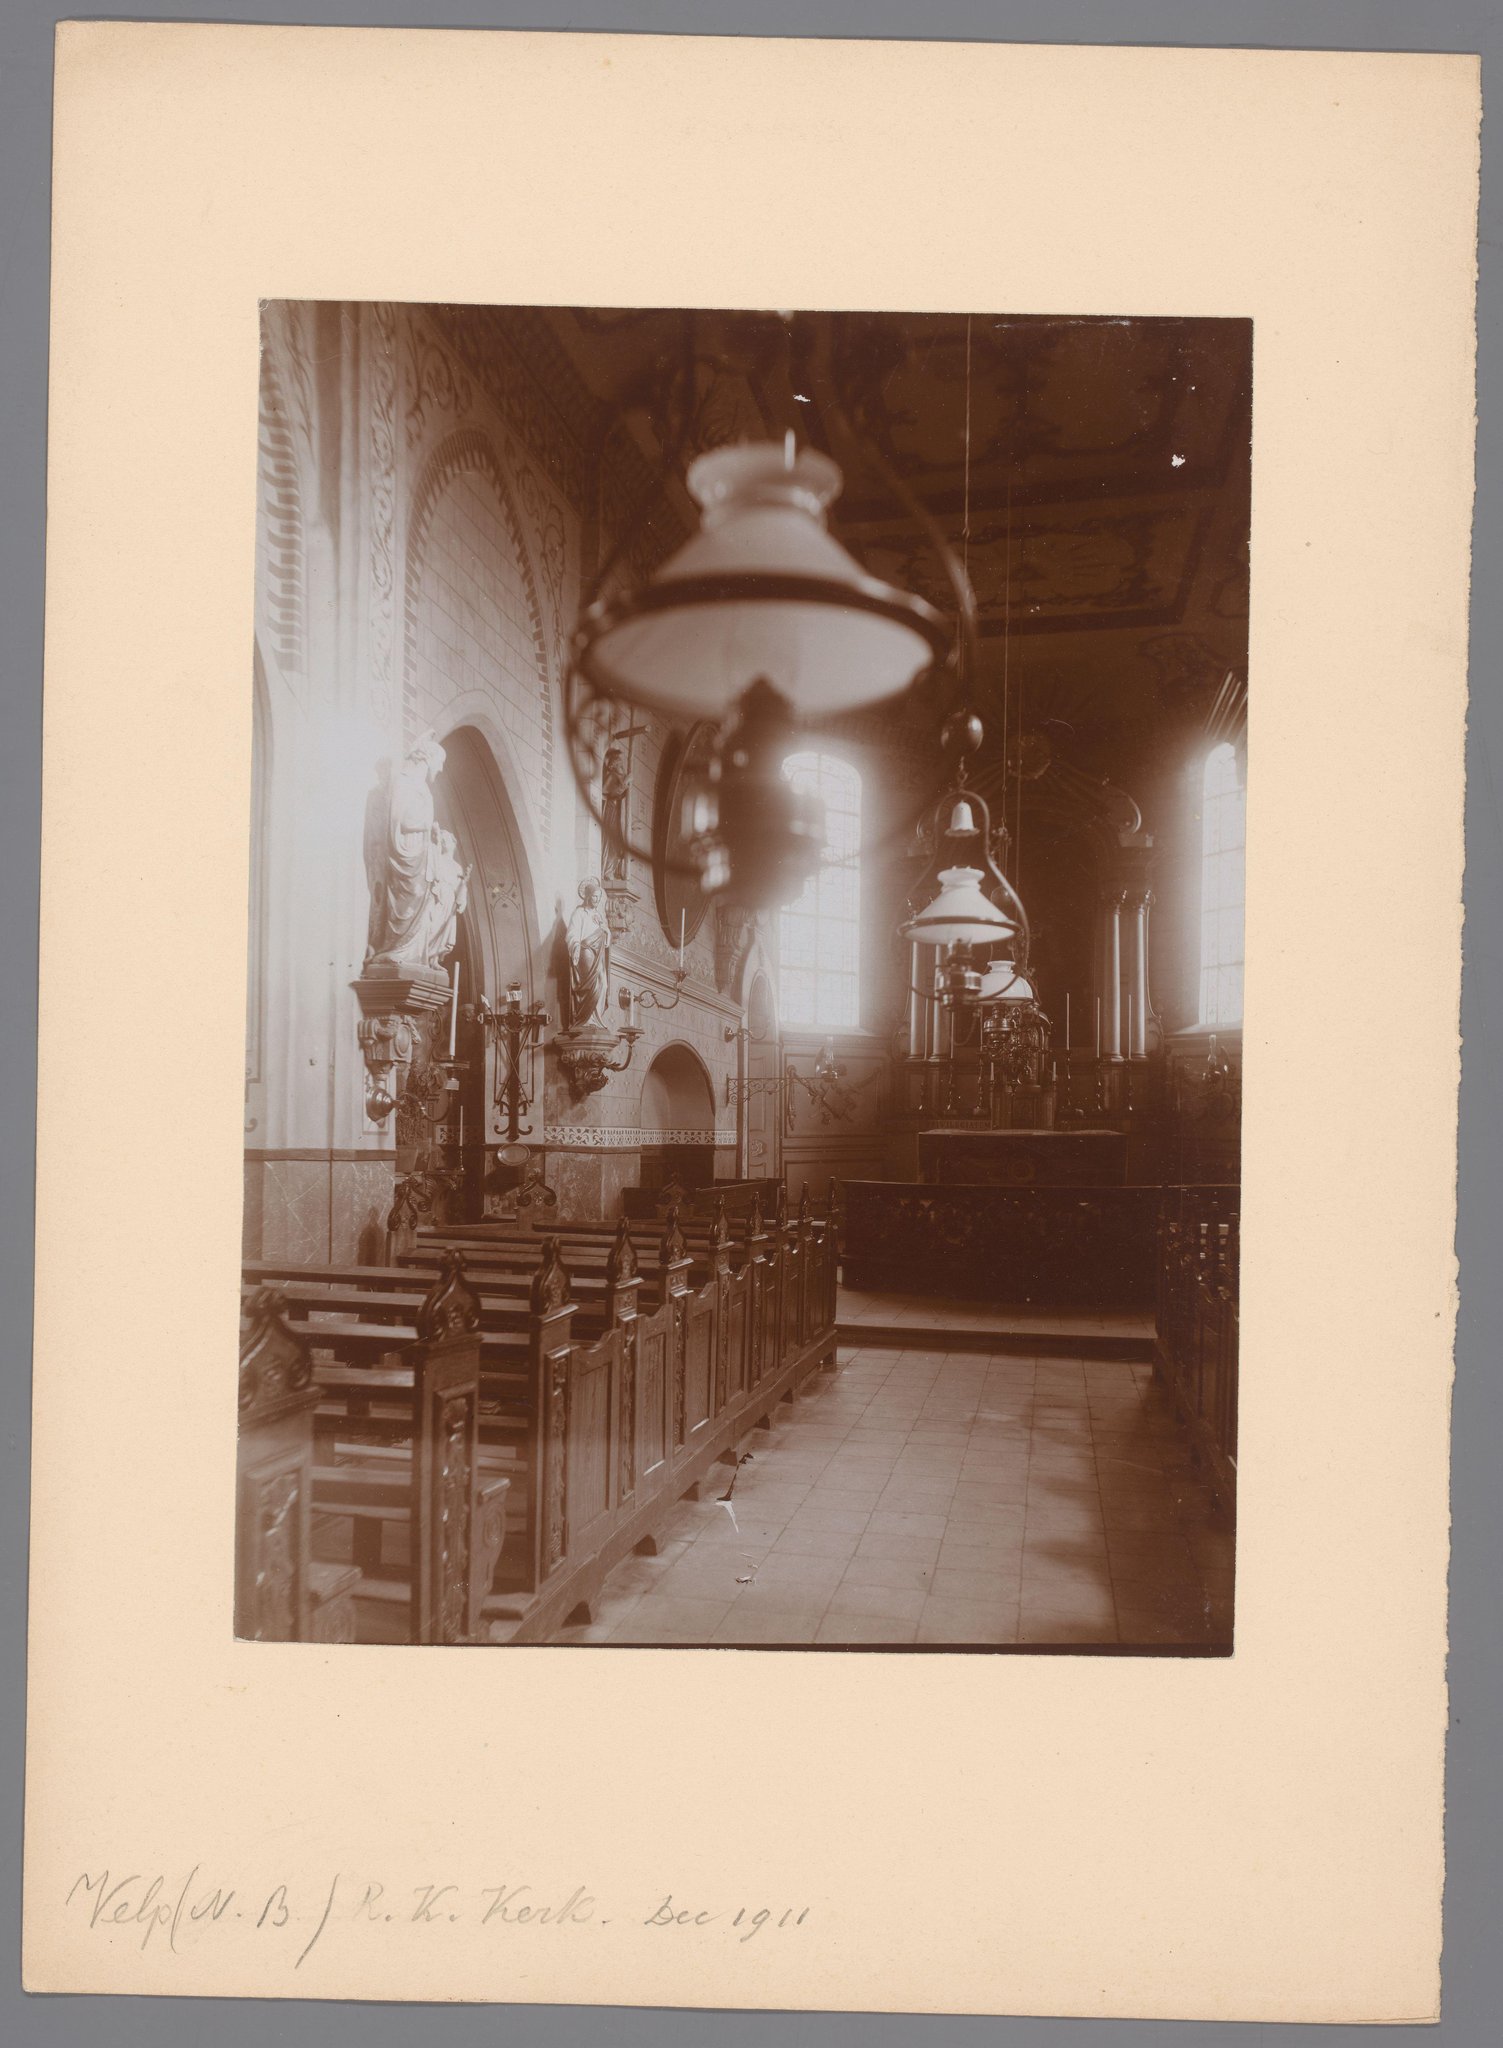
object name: photograph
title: Interieur van de Sint-Vincentiuskerk te Velp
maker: anoniem (monumentenzorg)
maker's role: fotograaf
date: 1911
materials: cardboard, photographic support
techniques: collodion silver print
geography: velp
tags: interior of church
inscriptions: annotation: ‘Velp (N.B.) R.K. Kerk dec 1911’